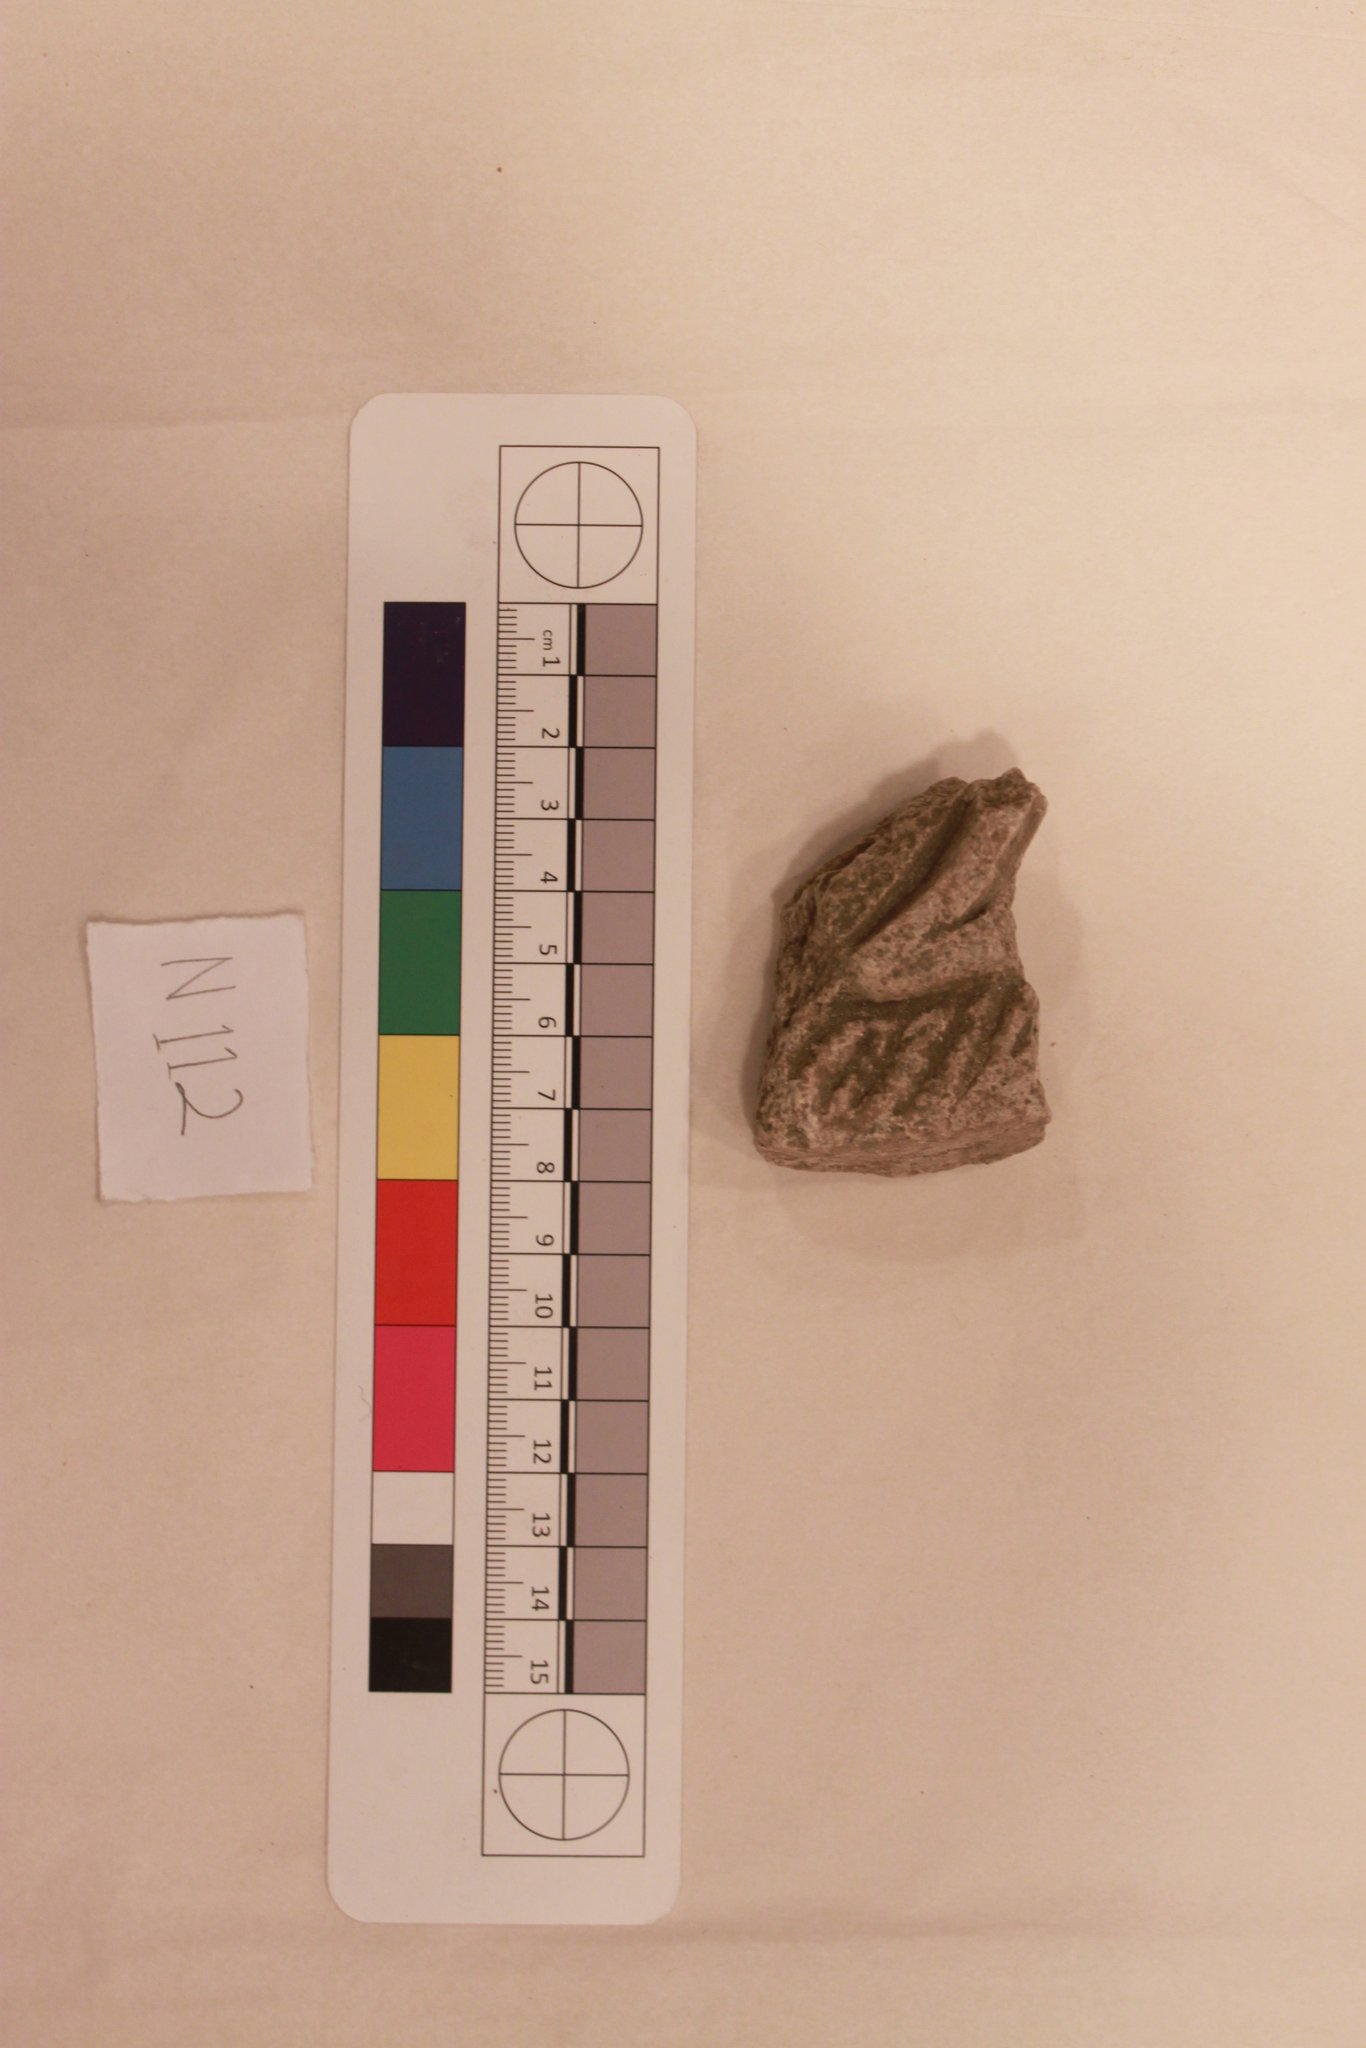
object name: fragment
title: Stucco Fragment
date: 701-1200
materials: plaster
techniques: carving, painting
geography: iran